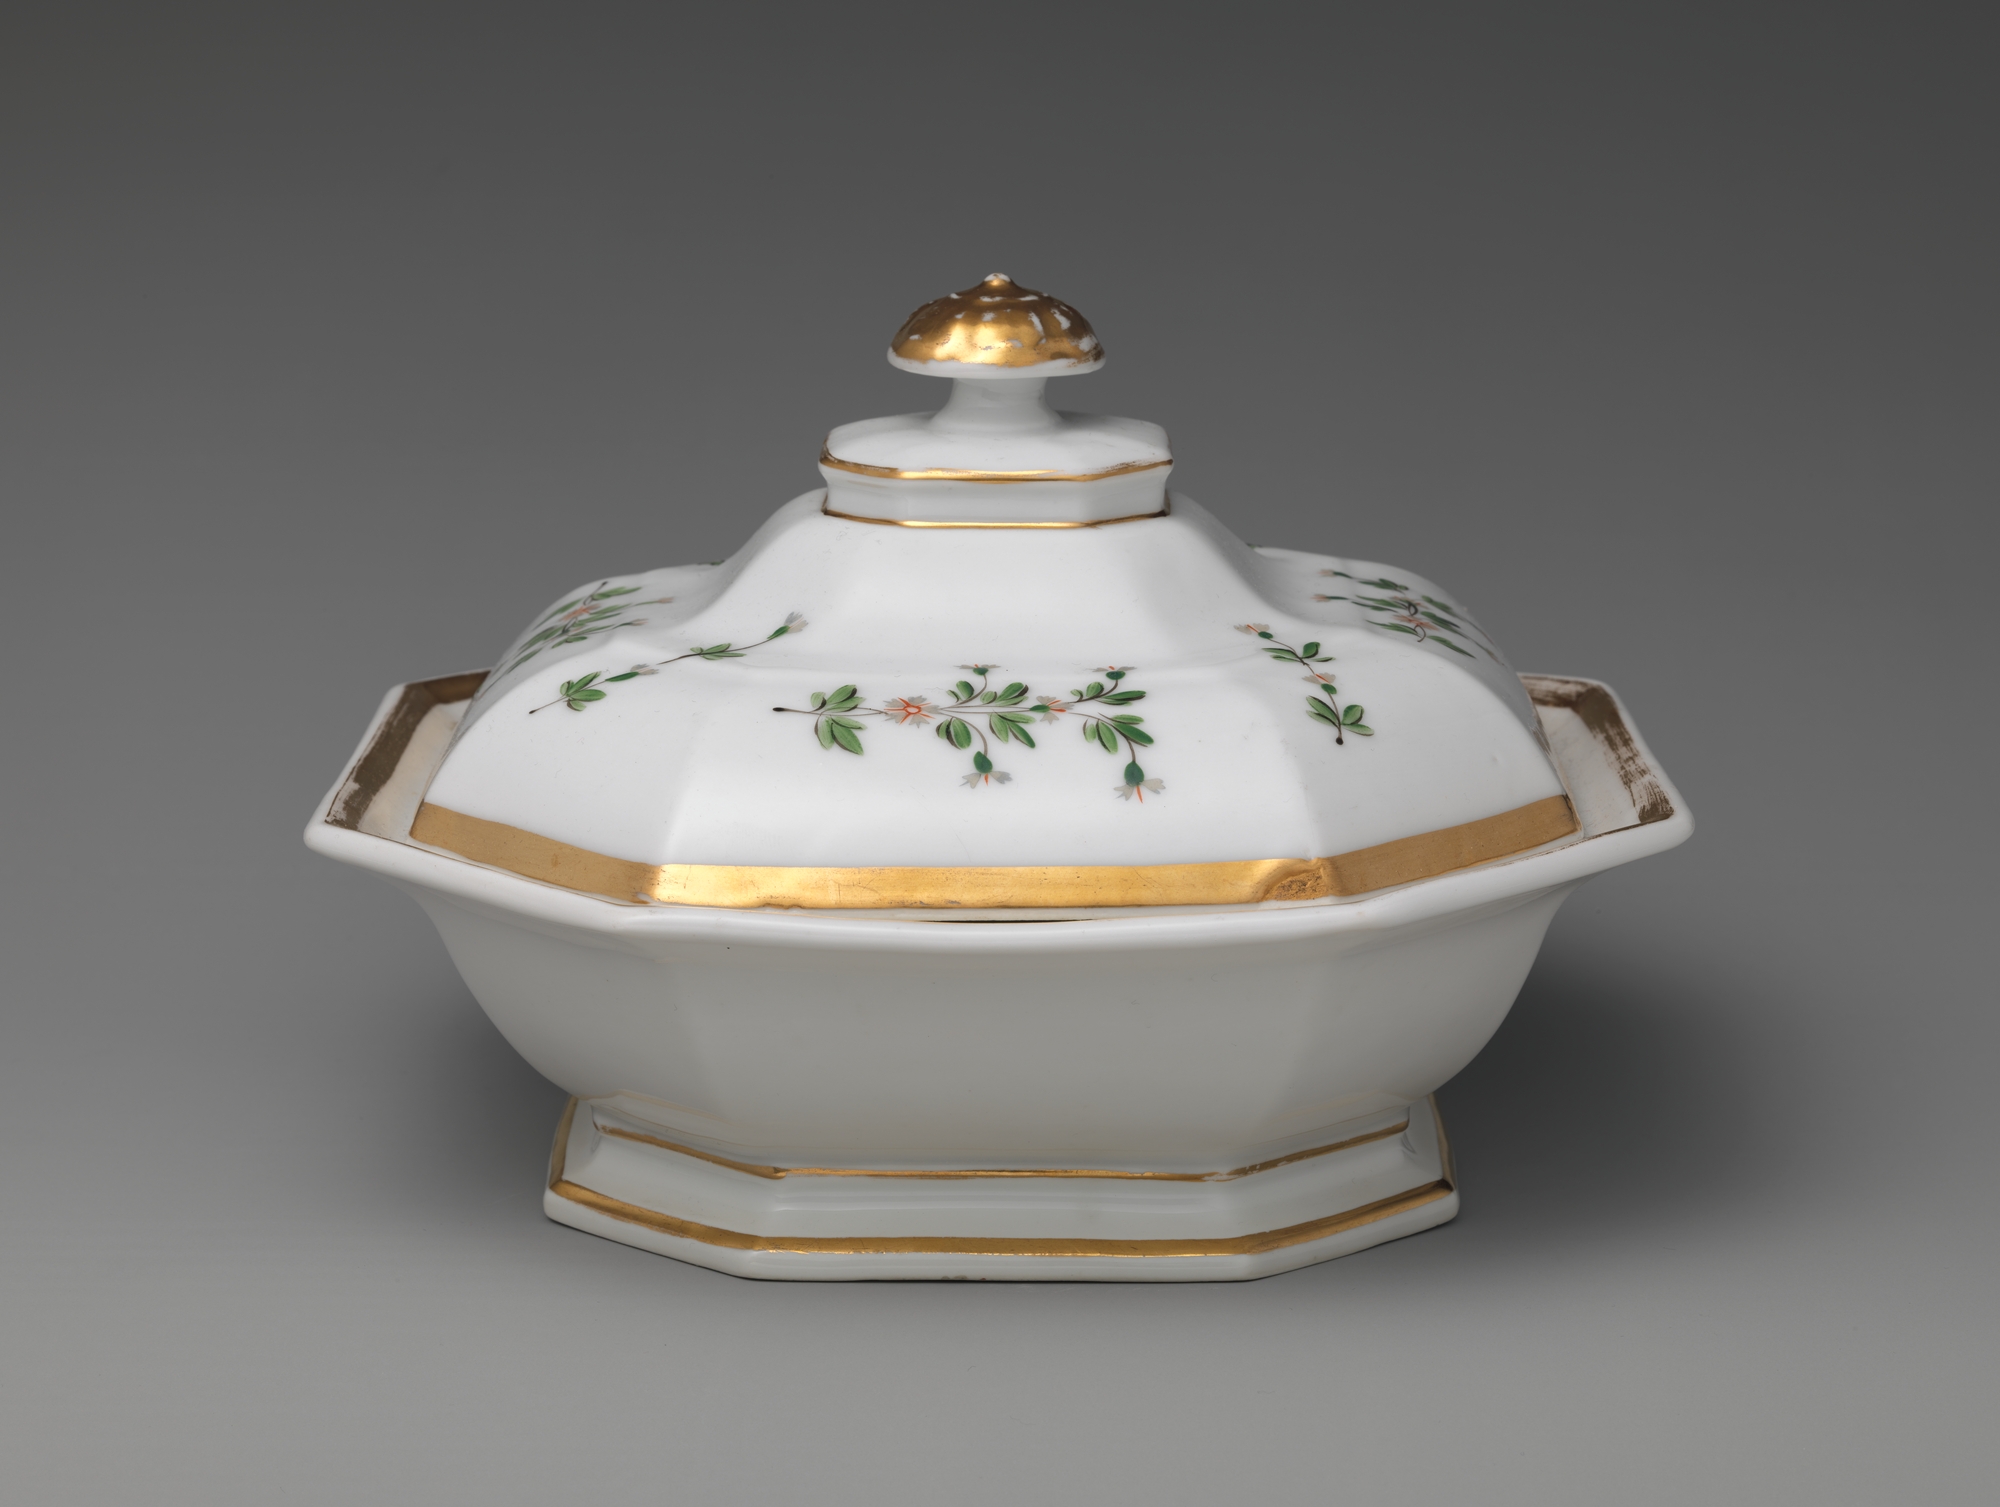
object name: dish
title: Covered Dish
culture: french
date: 1815-1830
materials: porcelain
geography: france